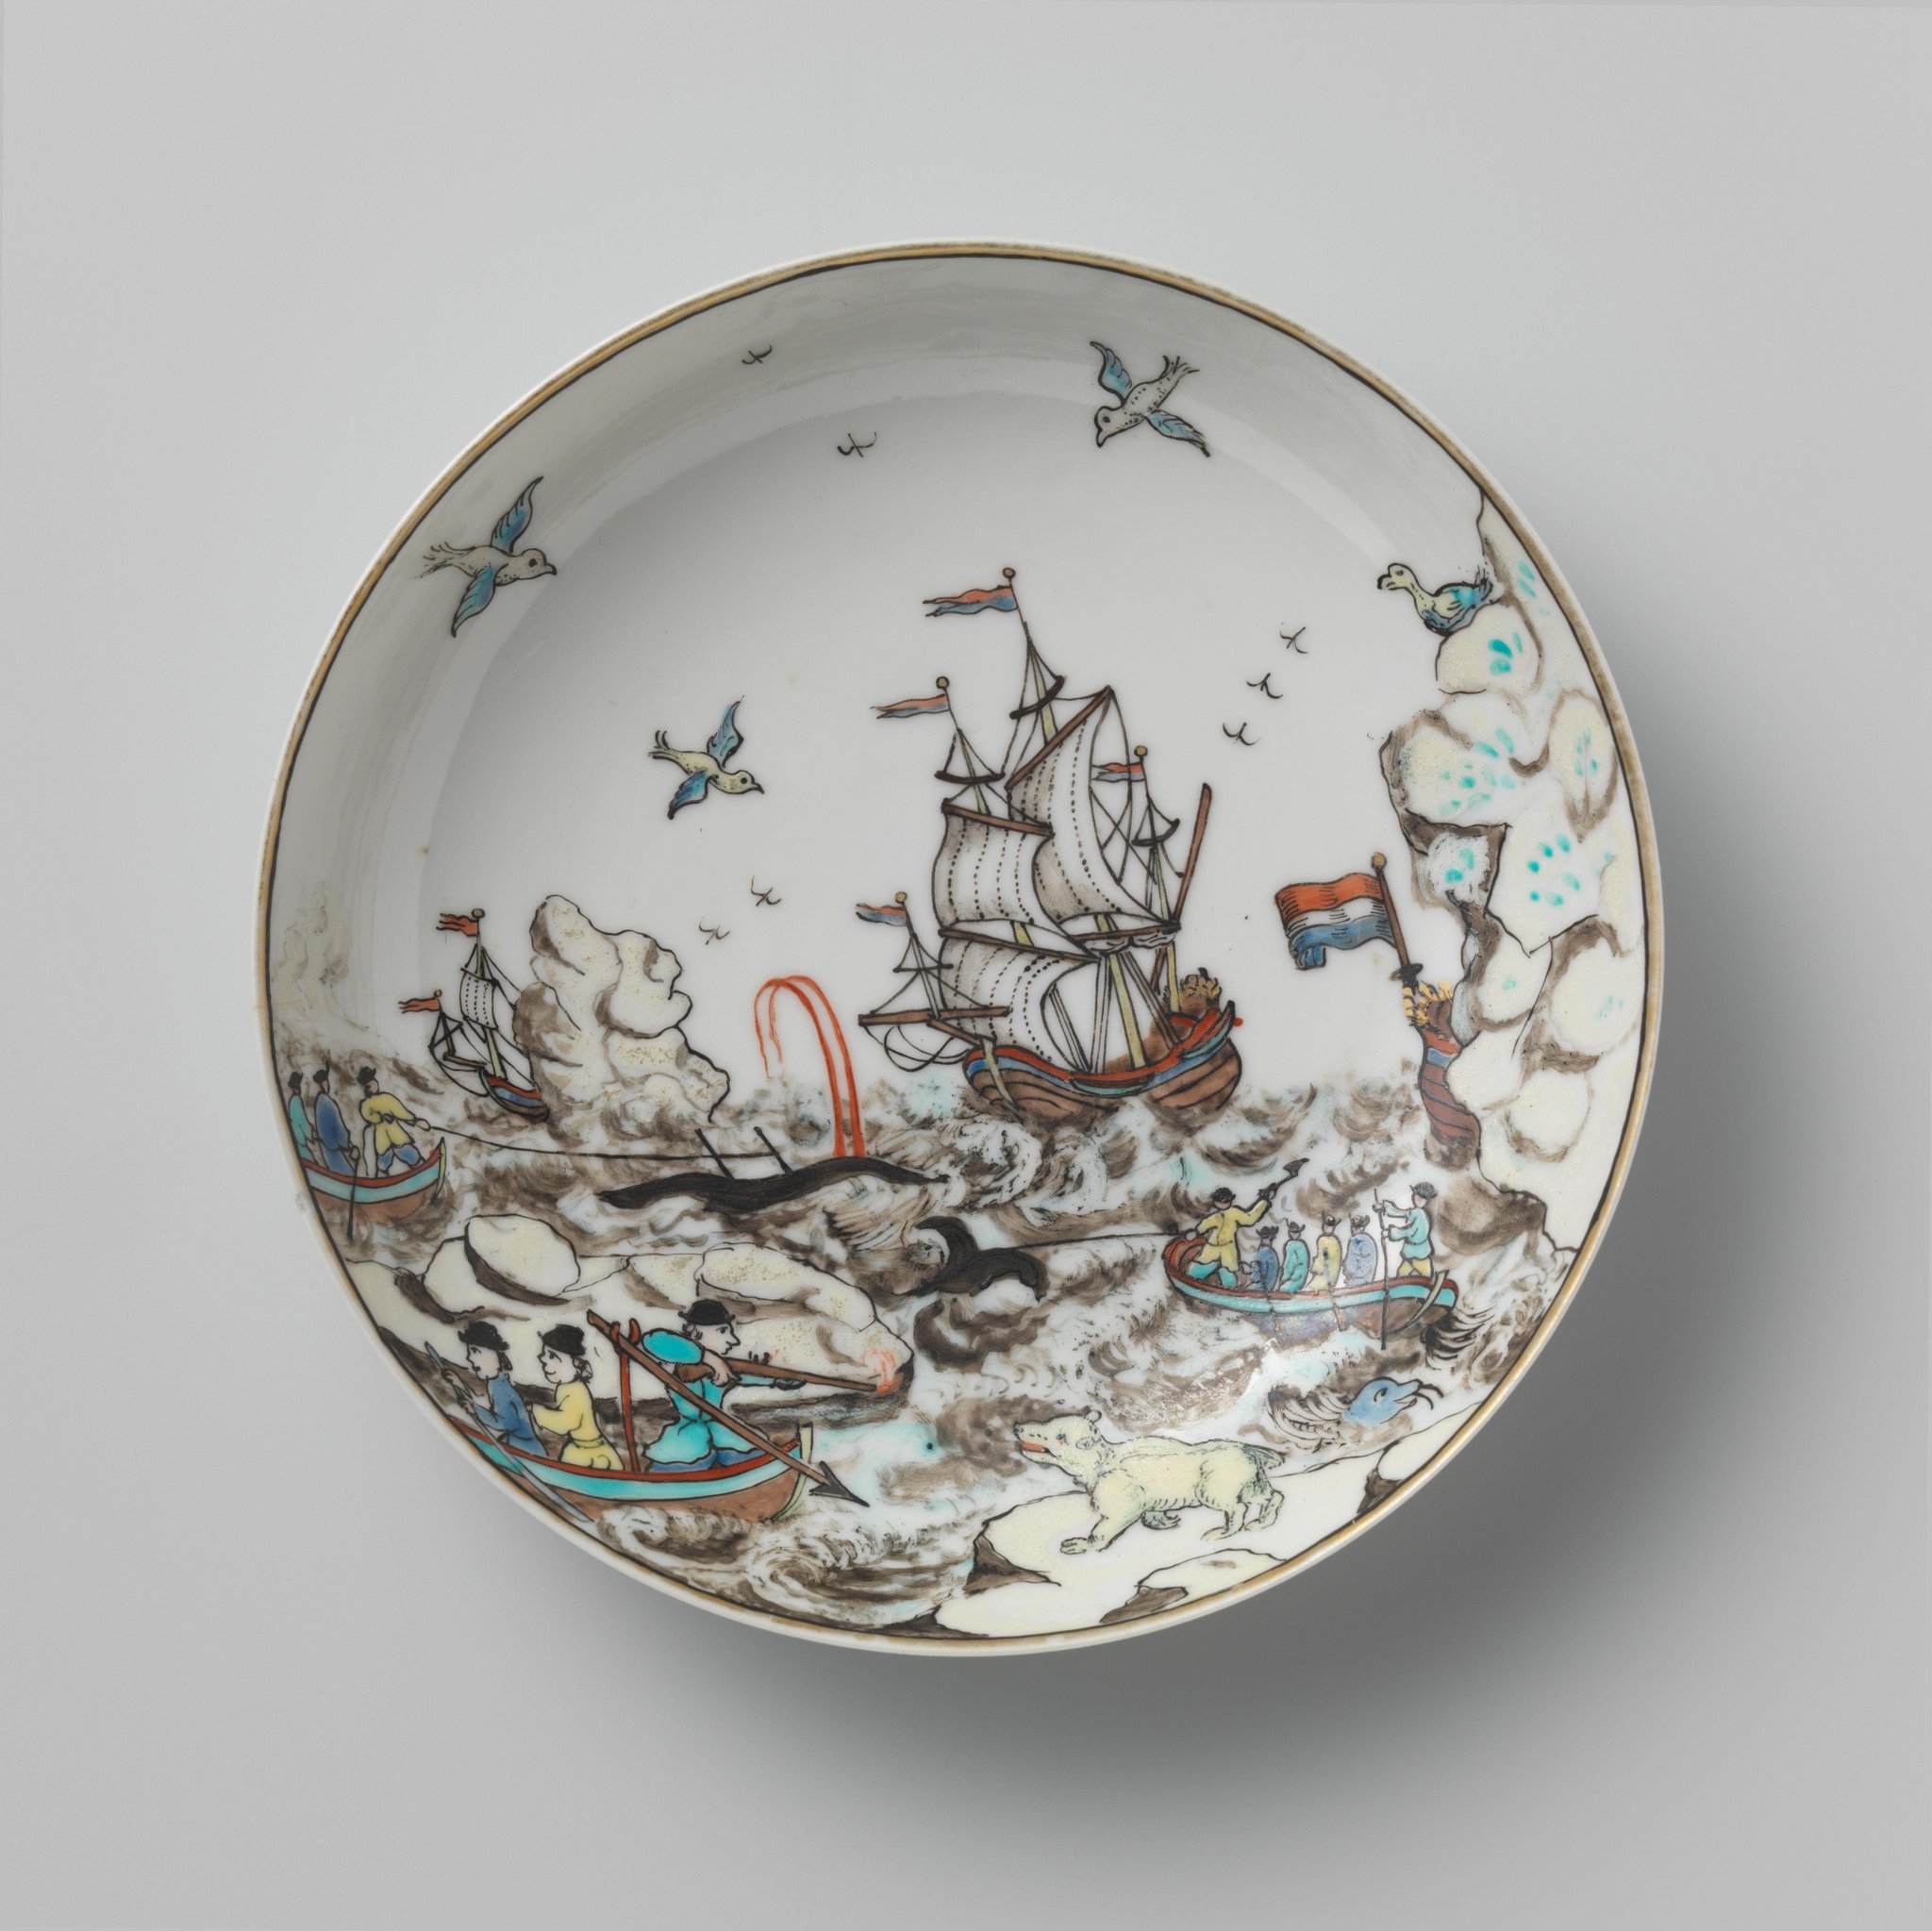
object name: platter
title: Saucer with a whaling scene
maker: Anonymous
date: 1700-1749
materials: glaze, gold, paint, porcelain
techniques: firing, gilding, turning, vitrification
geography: china